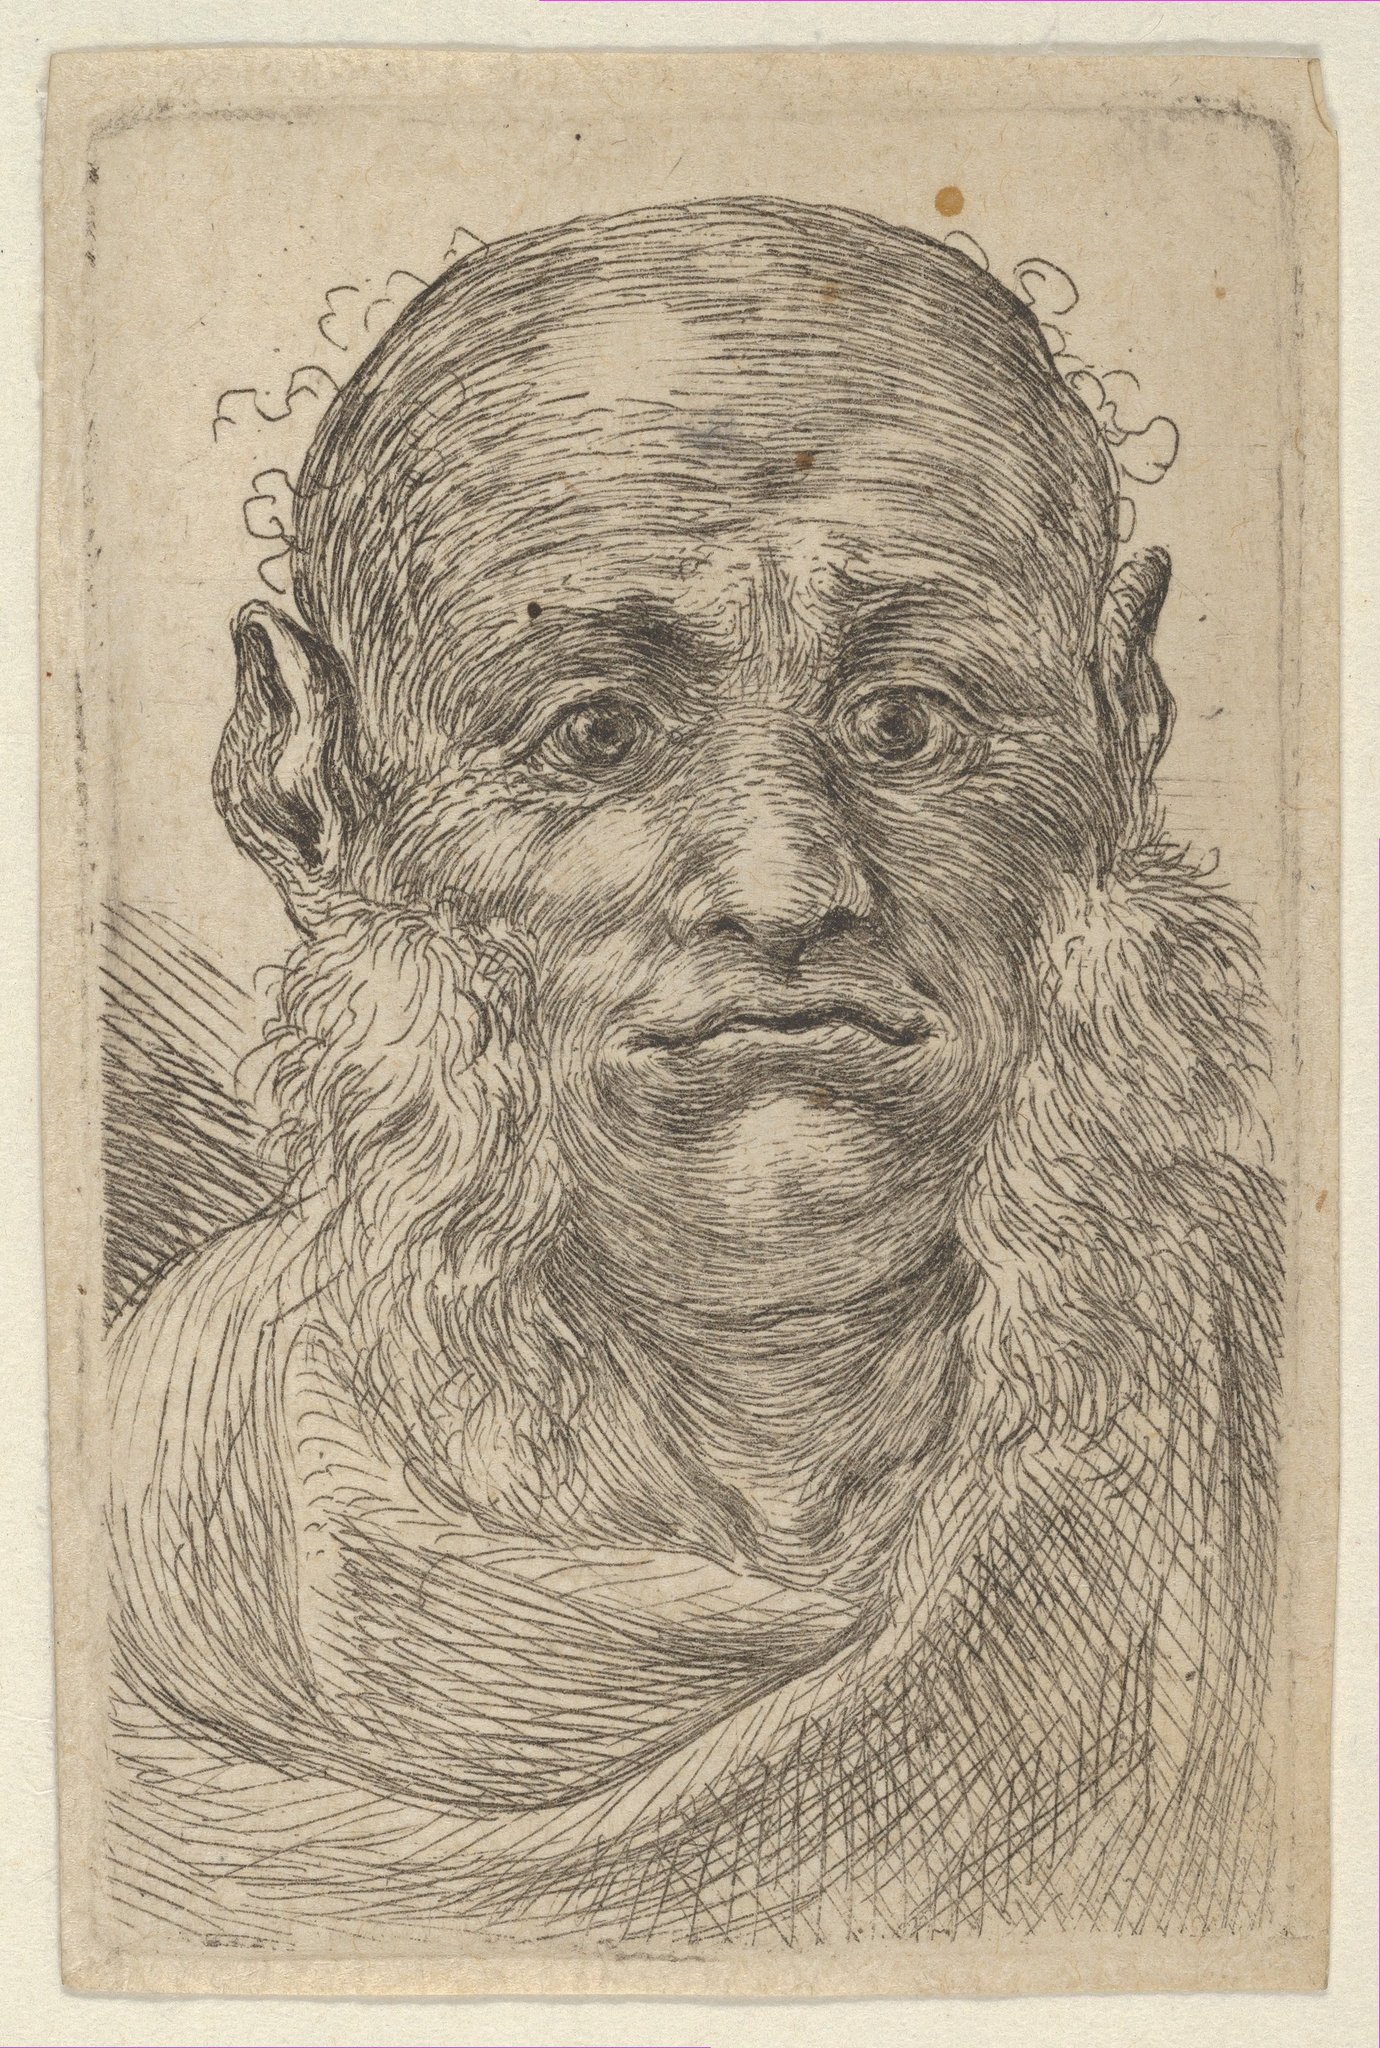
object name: print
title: Mask of a Bald Man with Tufty Sideburns, from "Divers Masques"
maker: françois chauveau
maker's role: artist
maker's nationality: french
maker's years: 1613-1676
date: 1635-1645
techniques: etching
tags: masks,men